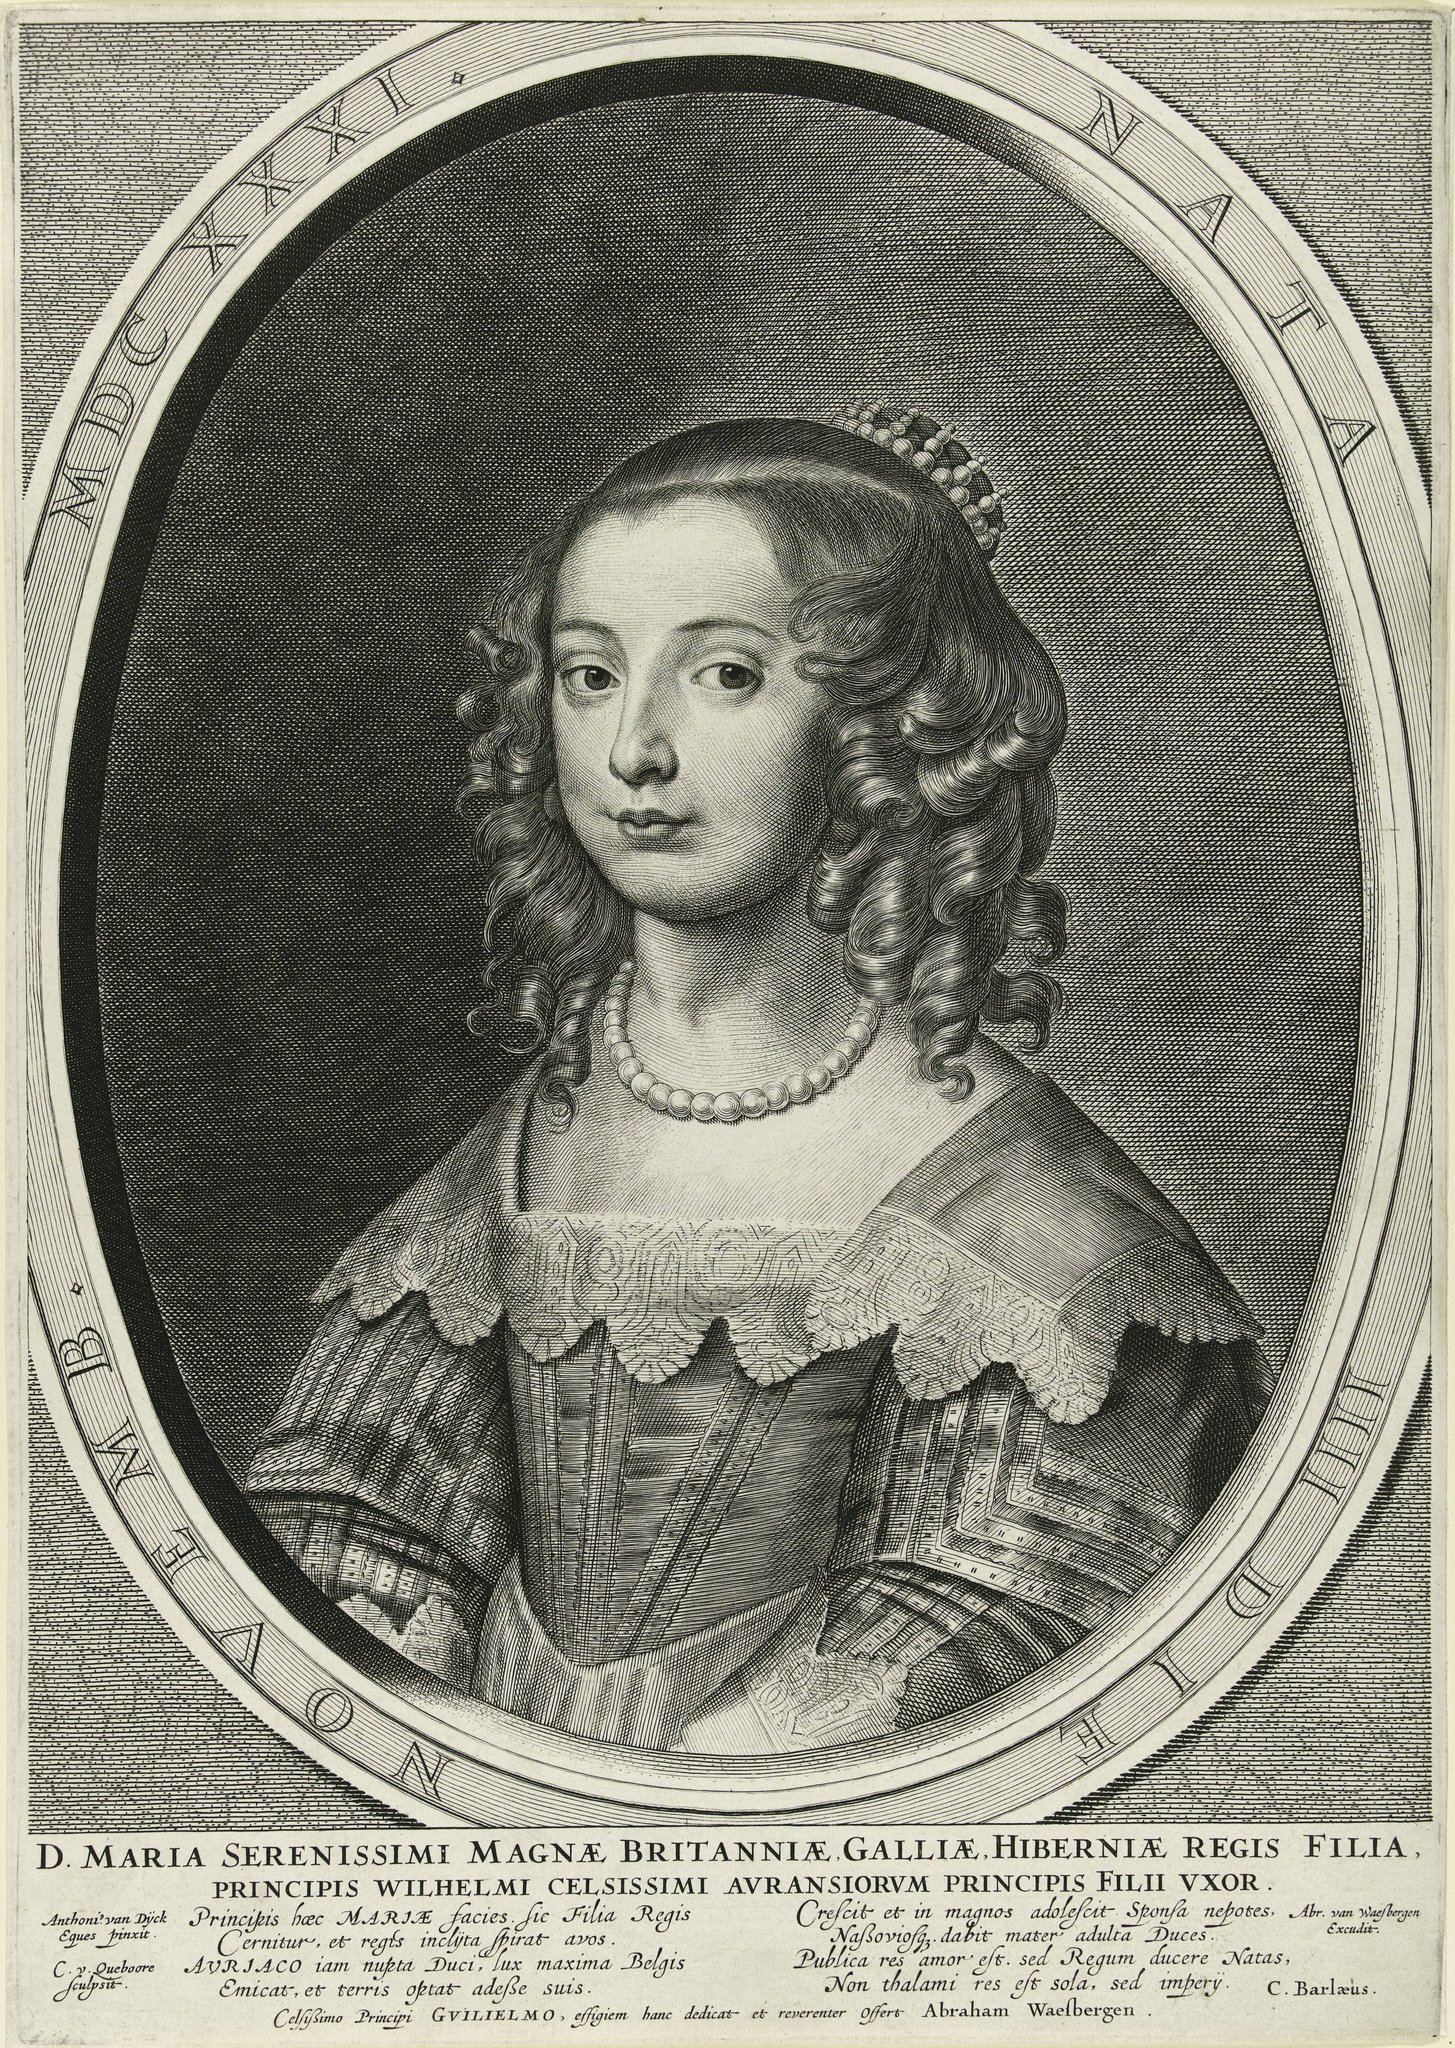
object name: print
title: Portret van Maria Henrietta Stuart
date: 1632-1644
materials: paper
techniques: engraving, etching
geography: the hague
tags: london, mary henrietta stuart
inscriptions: collector's mark: Lugt 2228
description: Portret van Maria Henrietta in een ovaal met randschrift. In de ondermarge twee regels Latijnse tekst en twee kolommen met elk vier regels Latijnse tekst.